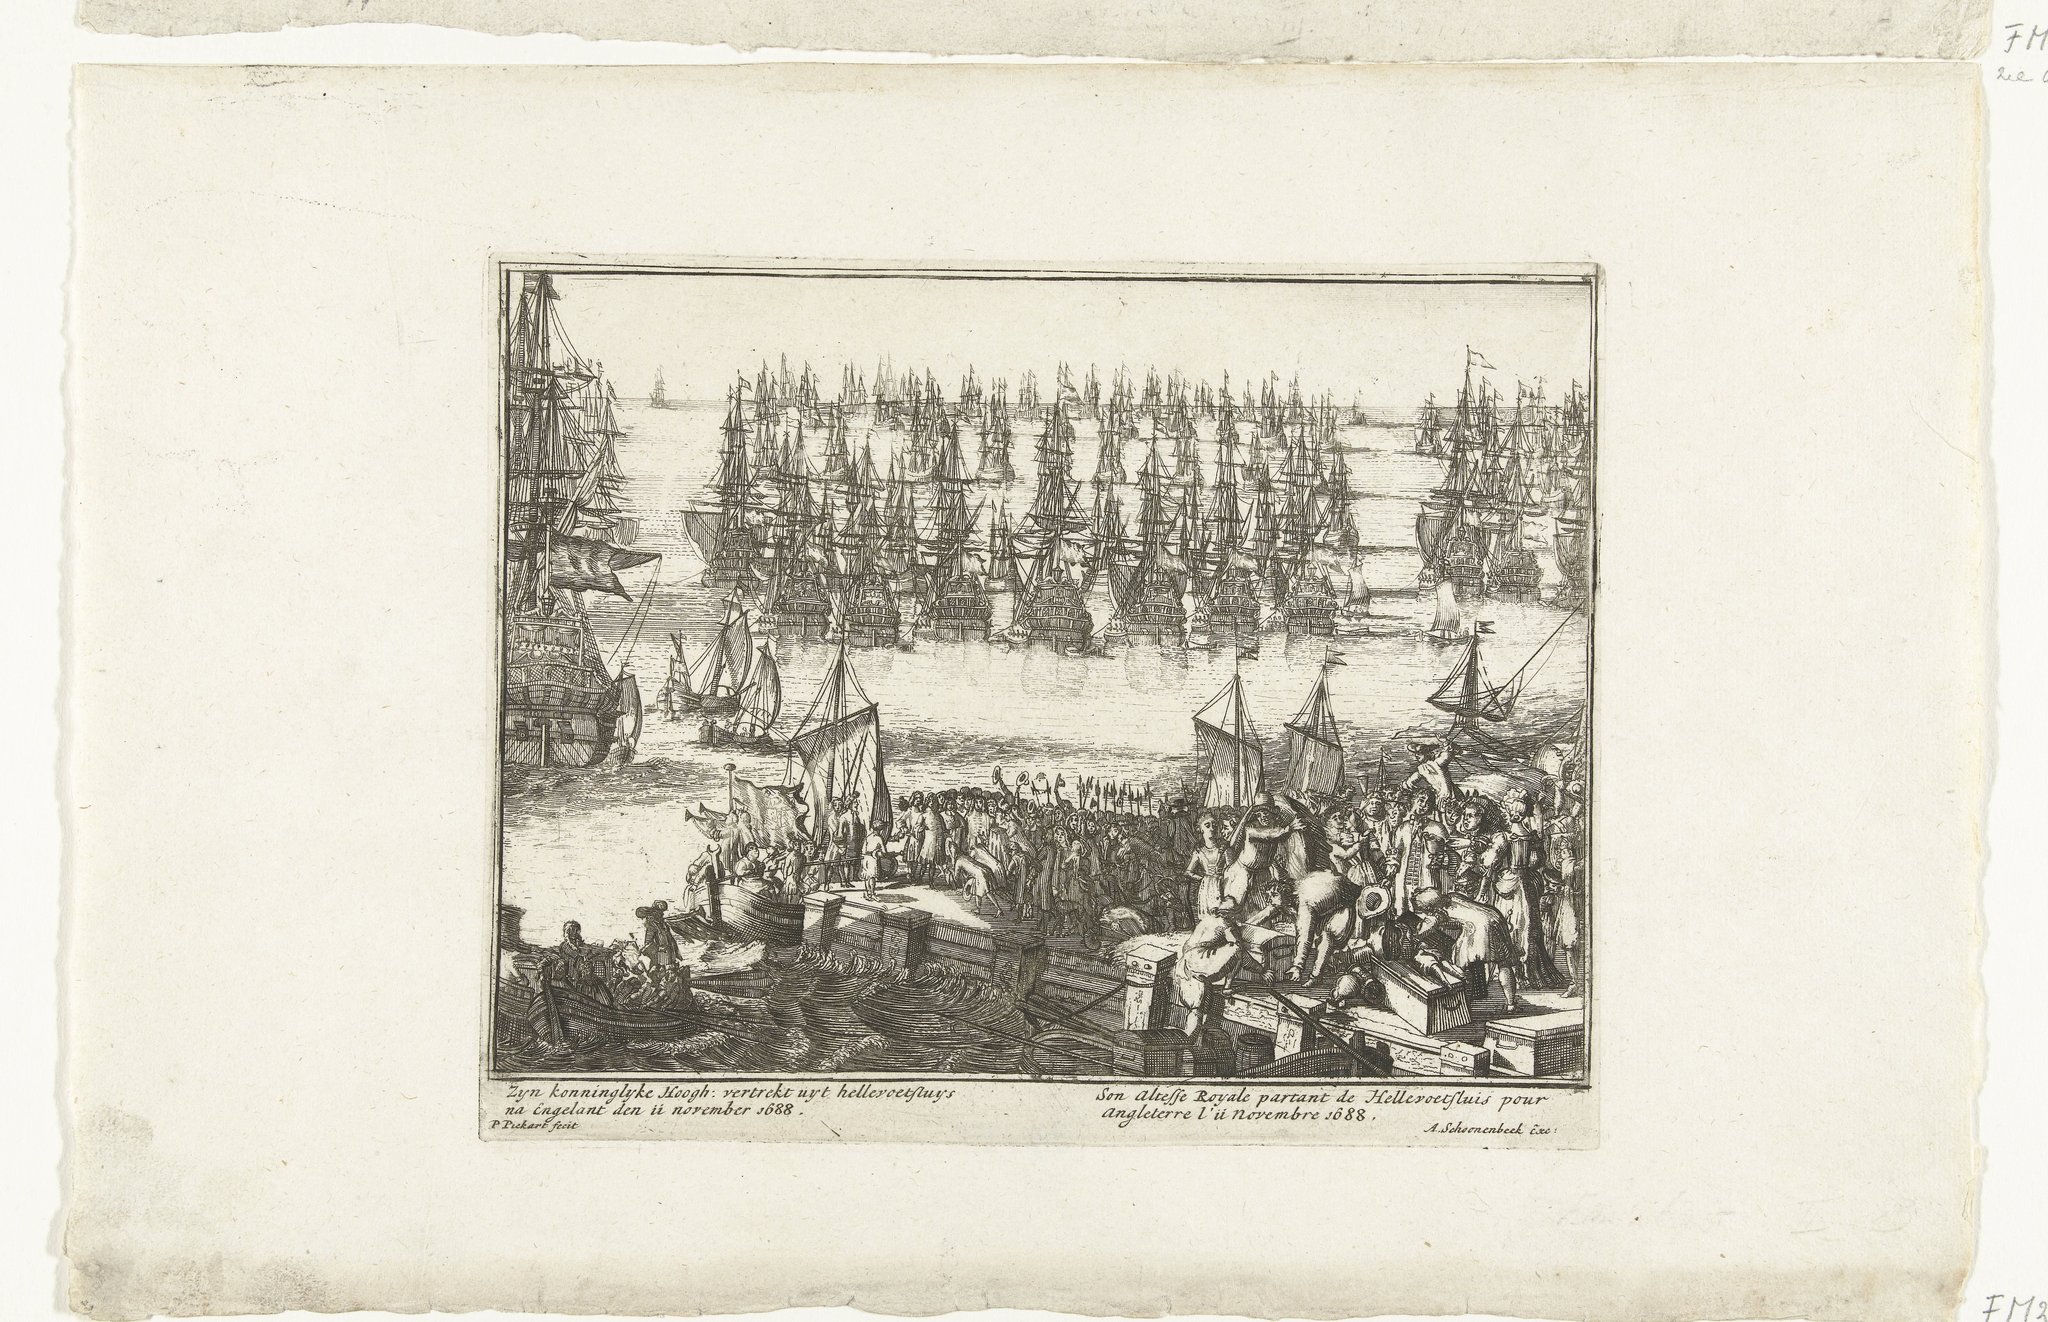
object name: print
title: Engelants schoutoneel verbeeldende de Glorieuse overtogt met het kroonen van William III en Maria II tot Koning en Koningin van groot Brittany en Vrankryk en Yrlant, etc. II Deel.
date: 1689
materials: paper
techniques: etching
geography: amsterdam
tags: the hague, william iii (prince of orange and king of england, scotland, and ireland), departure ~ travelling, hellevoetsluis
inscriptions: collector's mark: Lugt 2760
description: Prins Willem III vertrekt met de vloot vanuit Hellevoetsluis naar Engeland, 11 november 1688. De prins neemt op de pier afscheid. Onderdeel van de serie 'Engelants schouwtoneel' over de Glorious Revolution 1688-1689 (tweede deel). Met onderschriften in het Nederlands en Frans.